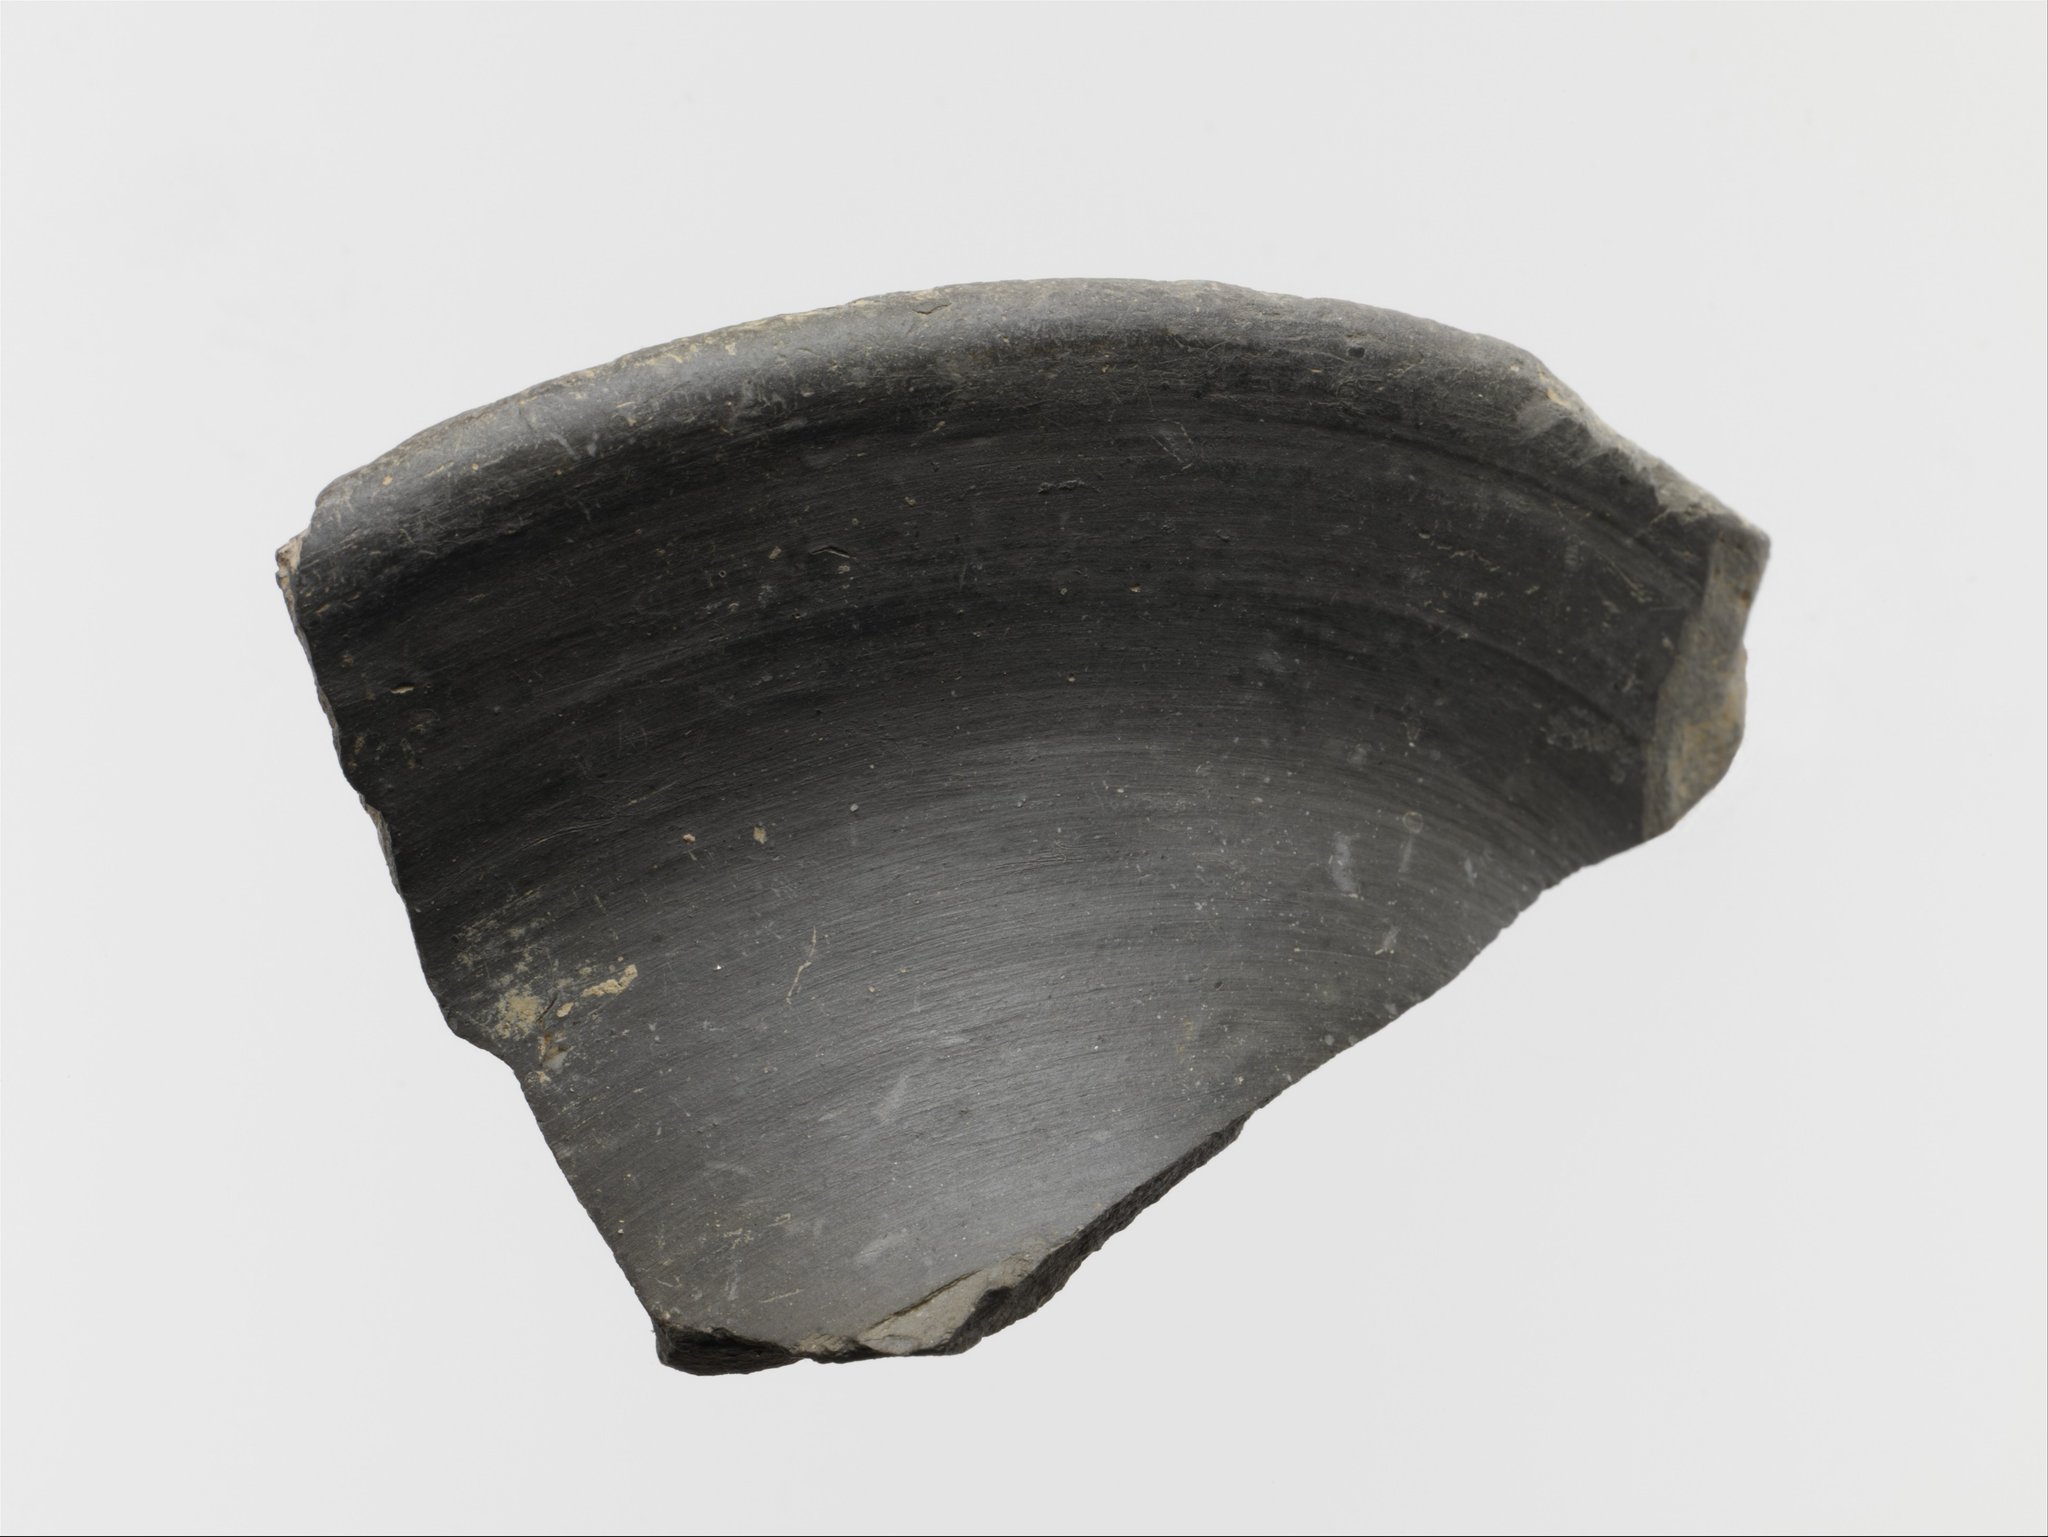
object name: vase fragment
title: Terracotta rim fragment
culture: helladic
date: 2100-1900 BCE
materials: terracotta